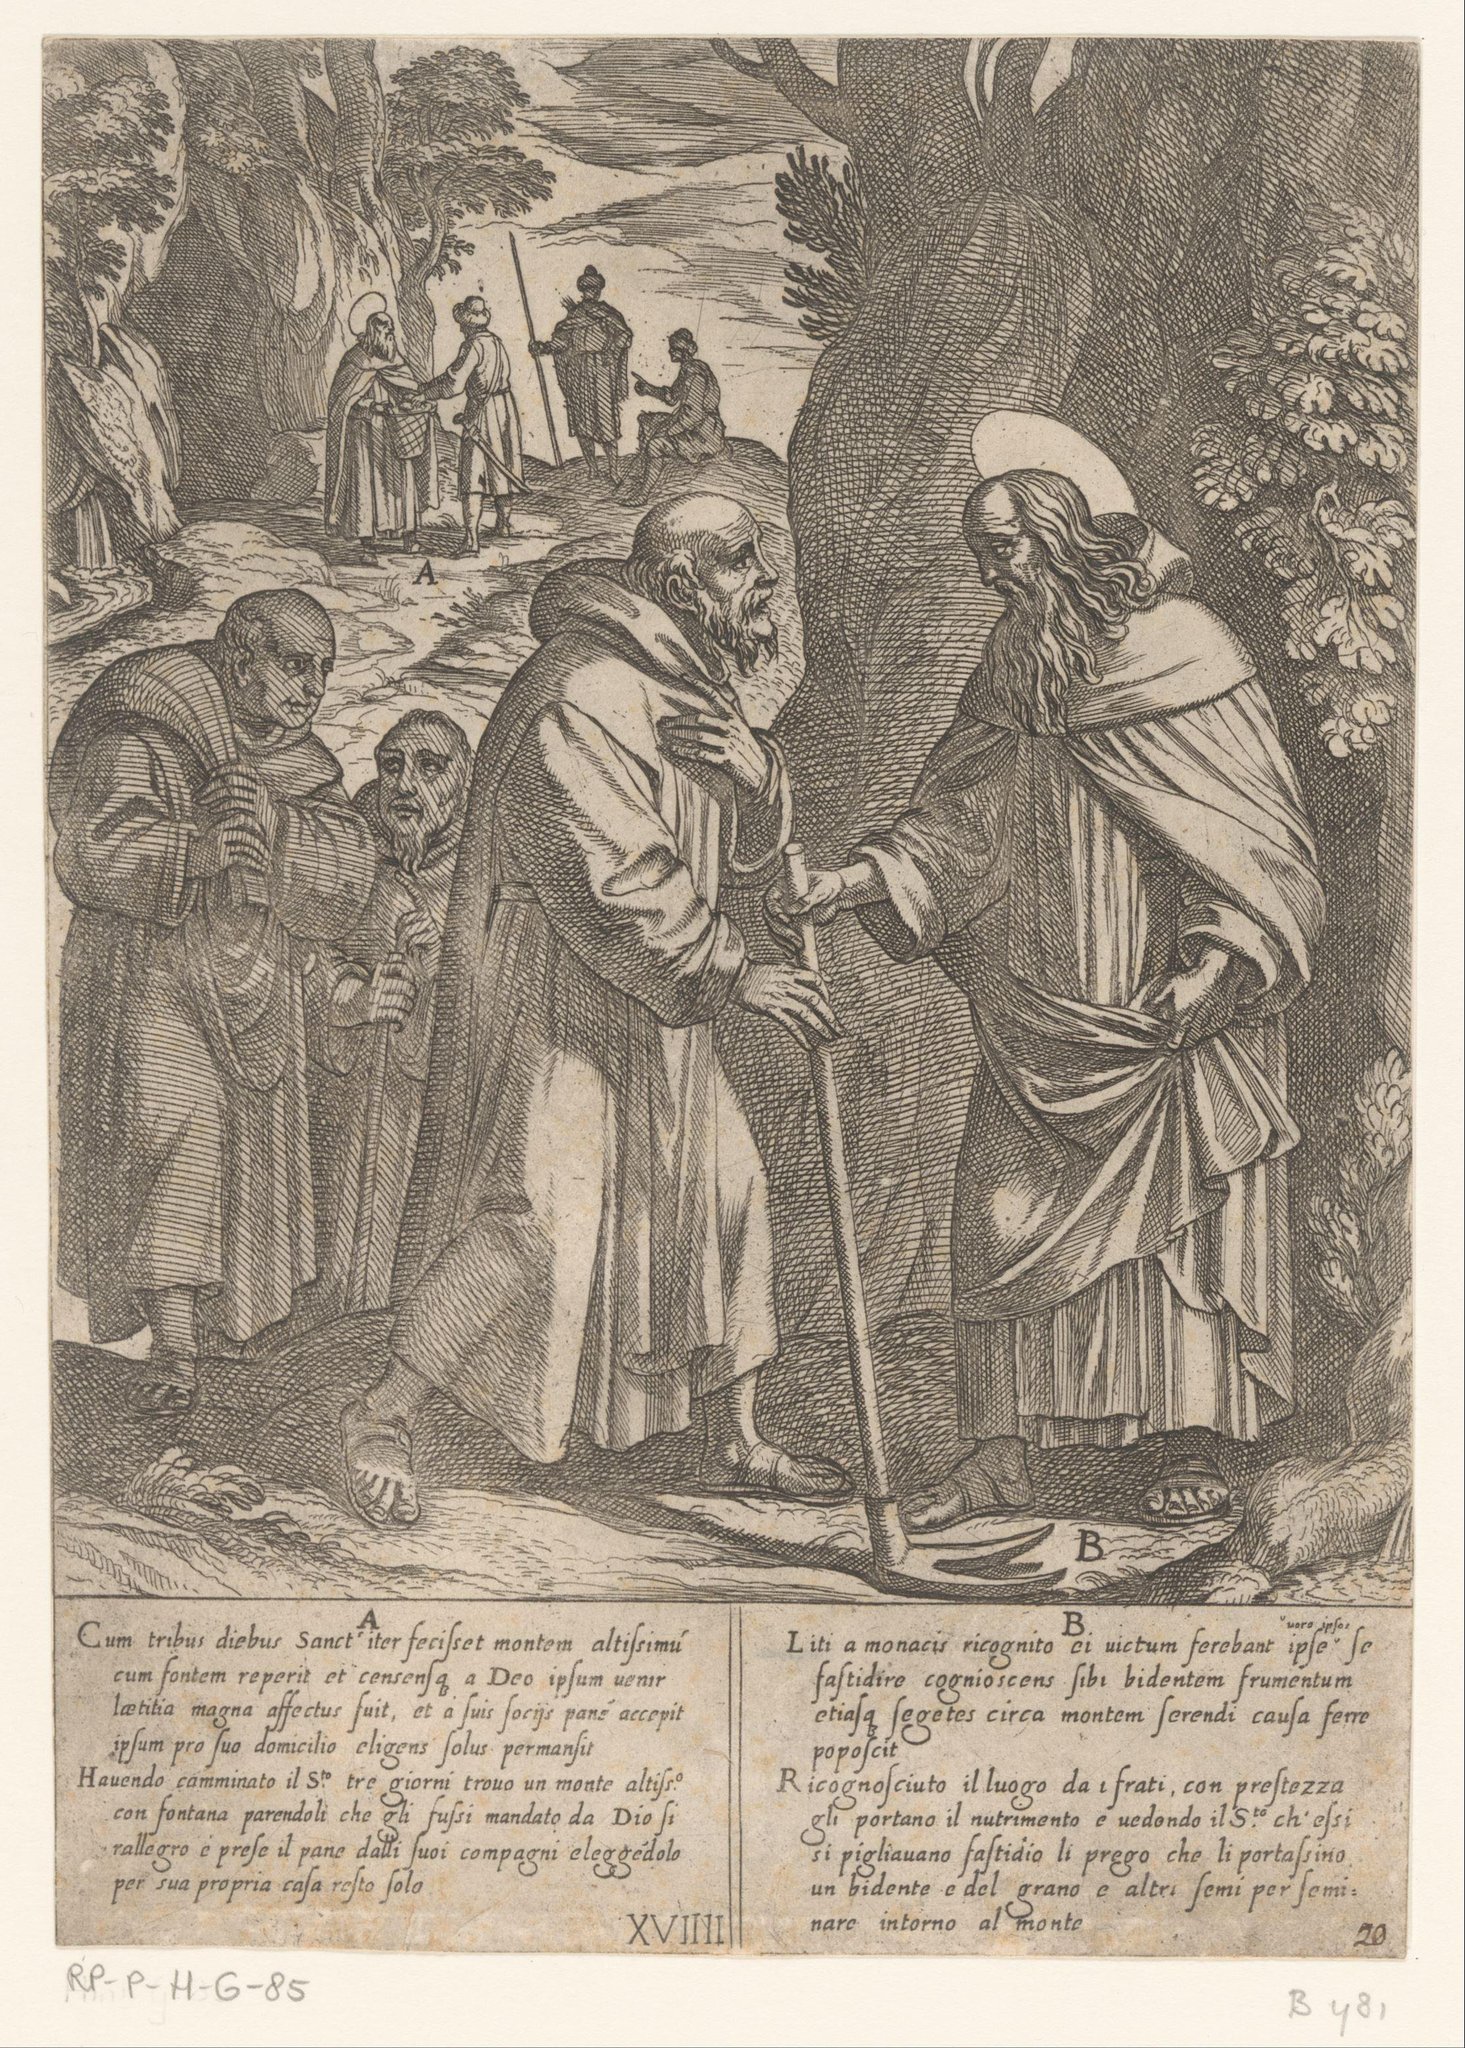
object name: print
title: H. Antonius ontvangt voedsel en gereedschap om de grond te bewerken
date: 1598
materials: paper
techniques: etching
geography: italy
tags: the hermit antony abbot (antonius abbas) of egypt, also called the great; possible attributes: bell, book, t-shaped staff, flames, pig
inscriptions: number: ‘20’, collector's mark: Lugt 11, collector's mark: ‘Hinloopen’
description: Deze prent maakt deel uit van een reeks van 27 prenten (+ titelprent) over het leven van de heilige Antonius, naar een frescocyclus in de S. Antonio Abbate in Rome door Giovanni Battista Lombardelli en Niccolò Circignani.